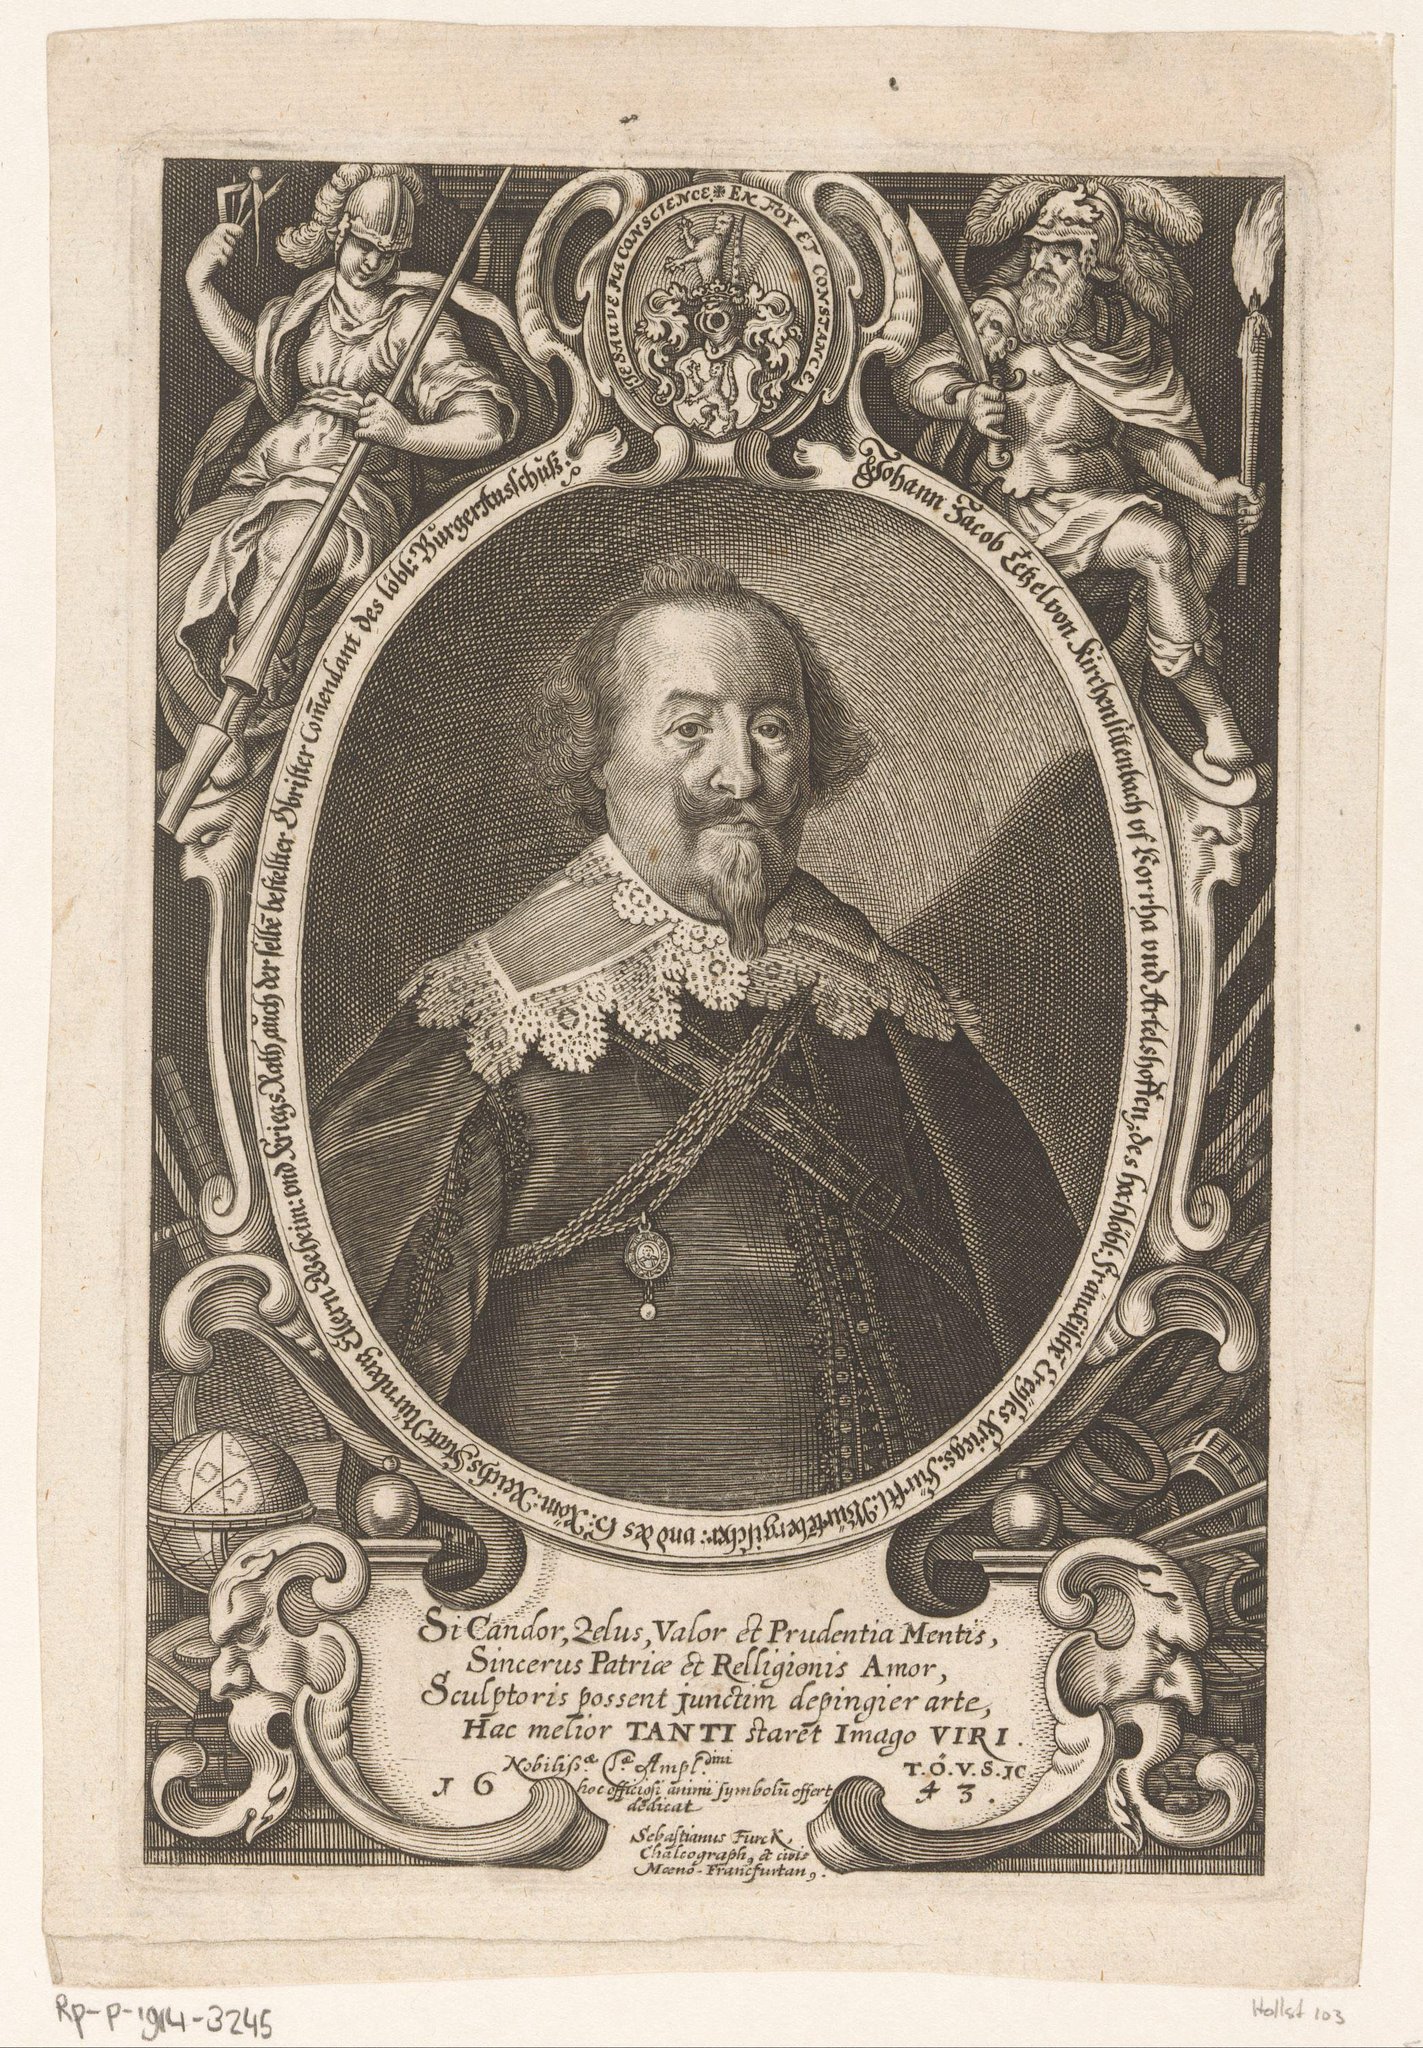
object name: print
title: Portret van Johann Jacob Tetzel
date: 1643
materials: paper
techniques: engraving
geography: frankfurt am main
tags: ornament ~ medallion, historical persons, pendant, trinket, 'breloque', ornament ~ cartouche, specific aspects, allegorical aspects of minerva; minerva as patroness, specific aspects, allegorical aspects of mars; mars as patron, armorial bearing, heraldry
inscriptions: collector's mark: Lugt 2228